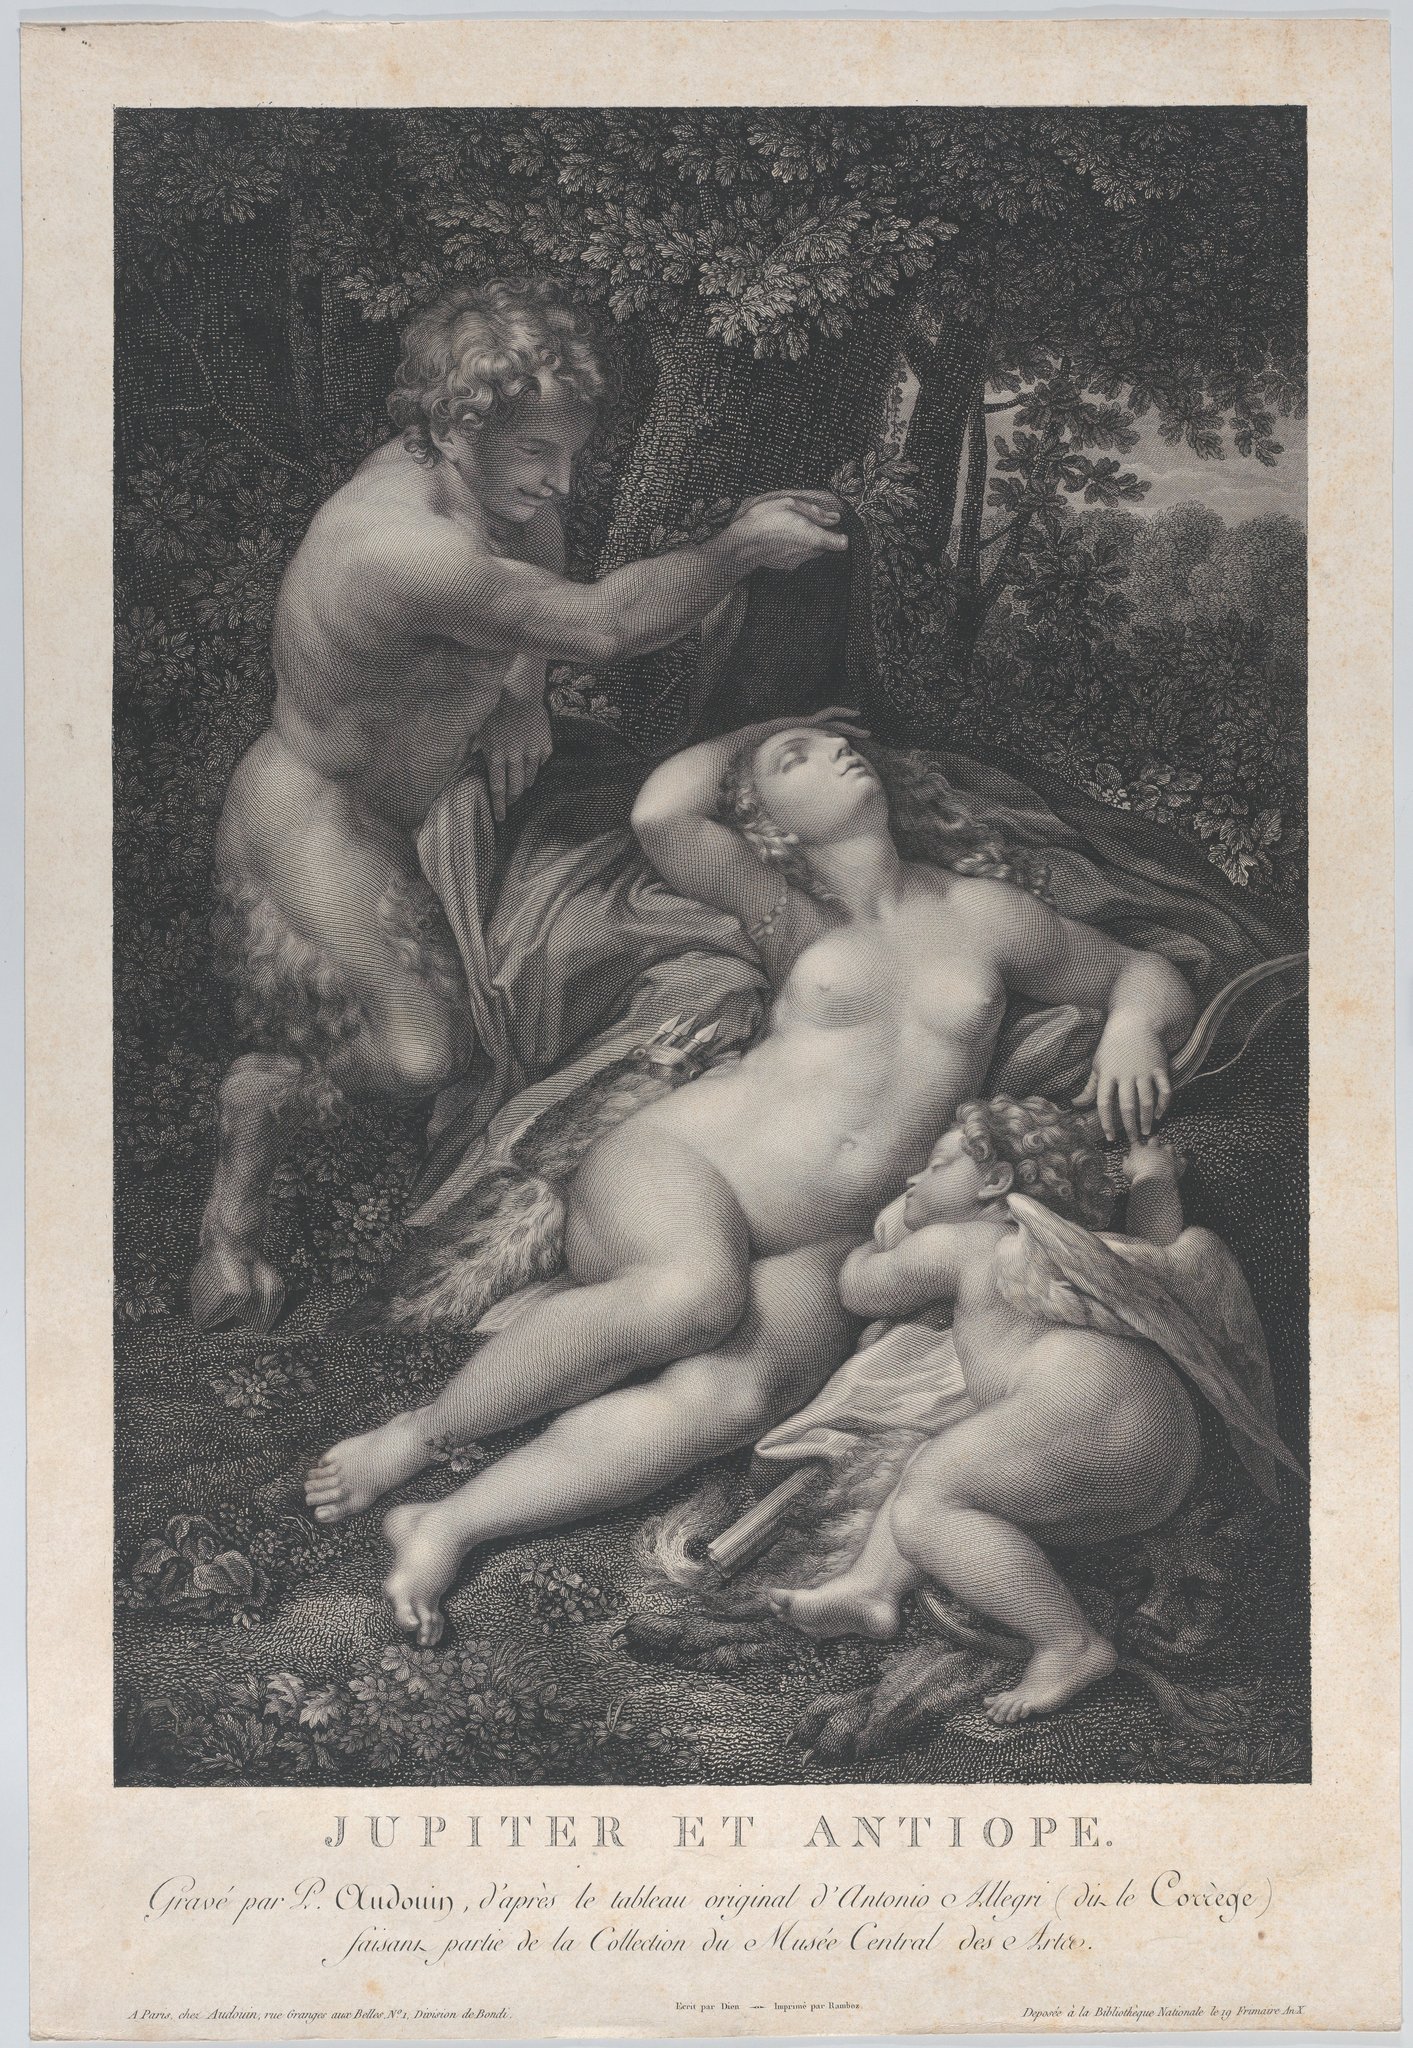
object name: print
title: A satyr discovering the sleeping Venus, with Cupid lying at her side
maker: pierre audouin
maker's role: artist and publisher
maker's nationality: french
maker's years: 1768-1822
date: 1801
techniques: engraving, etching